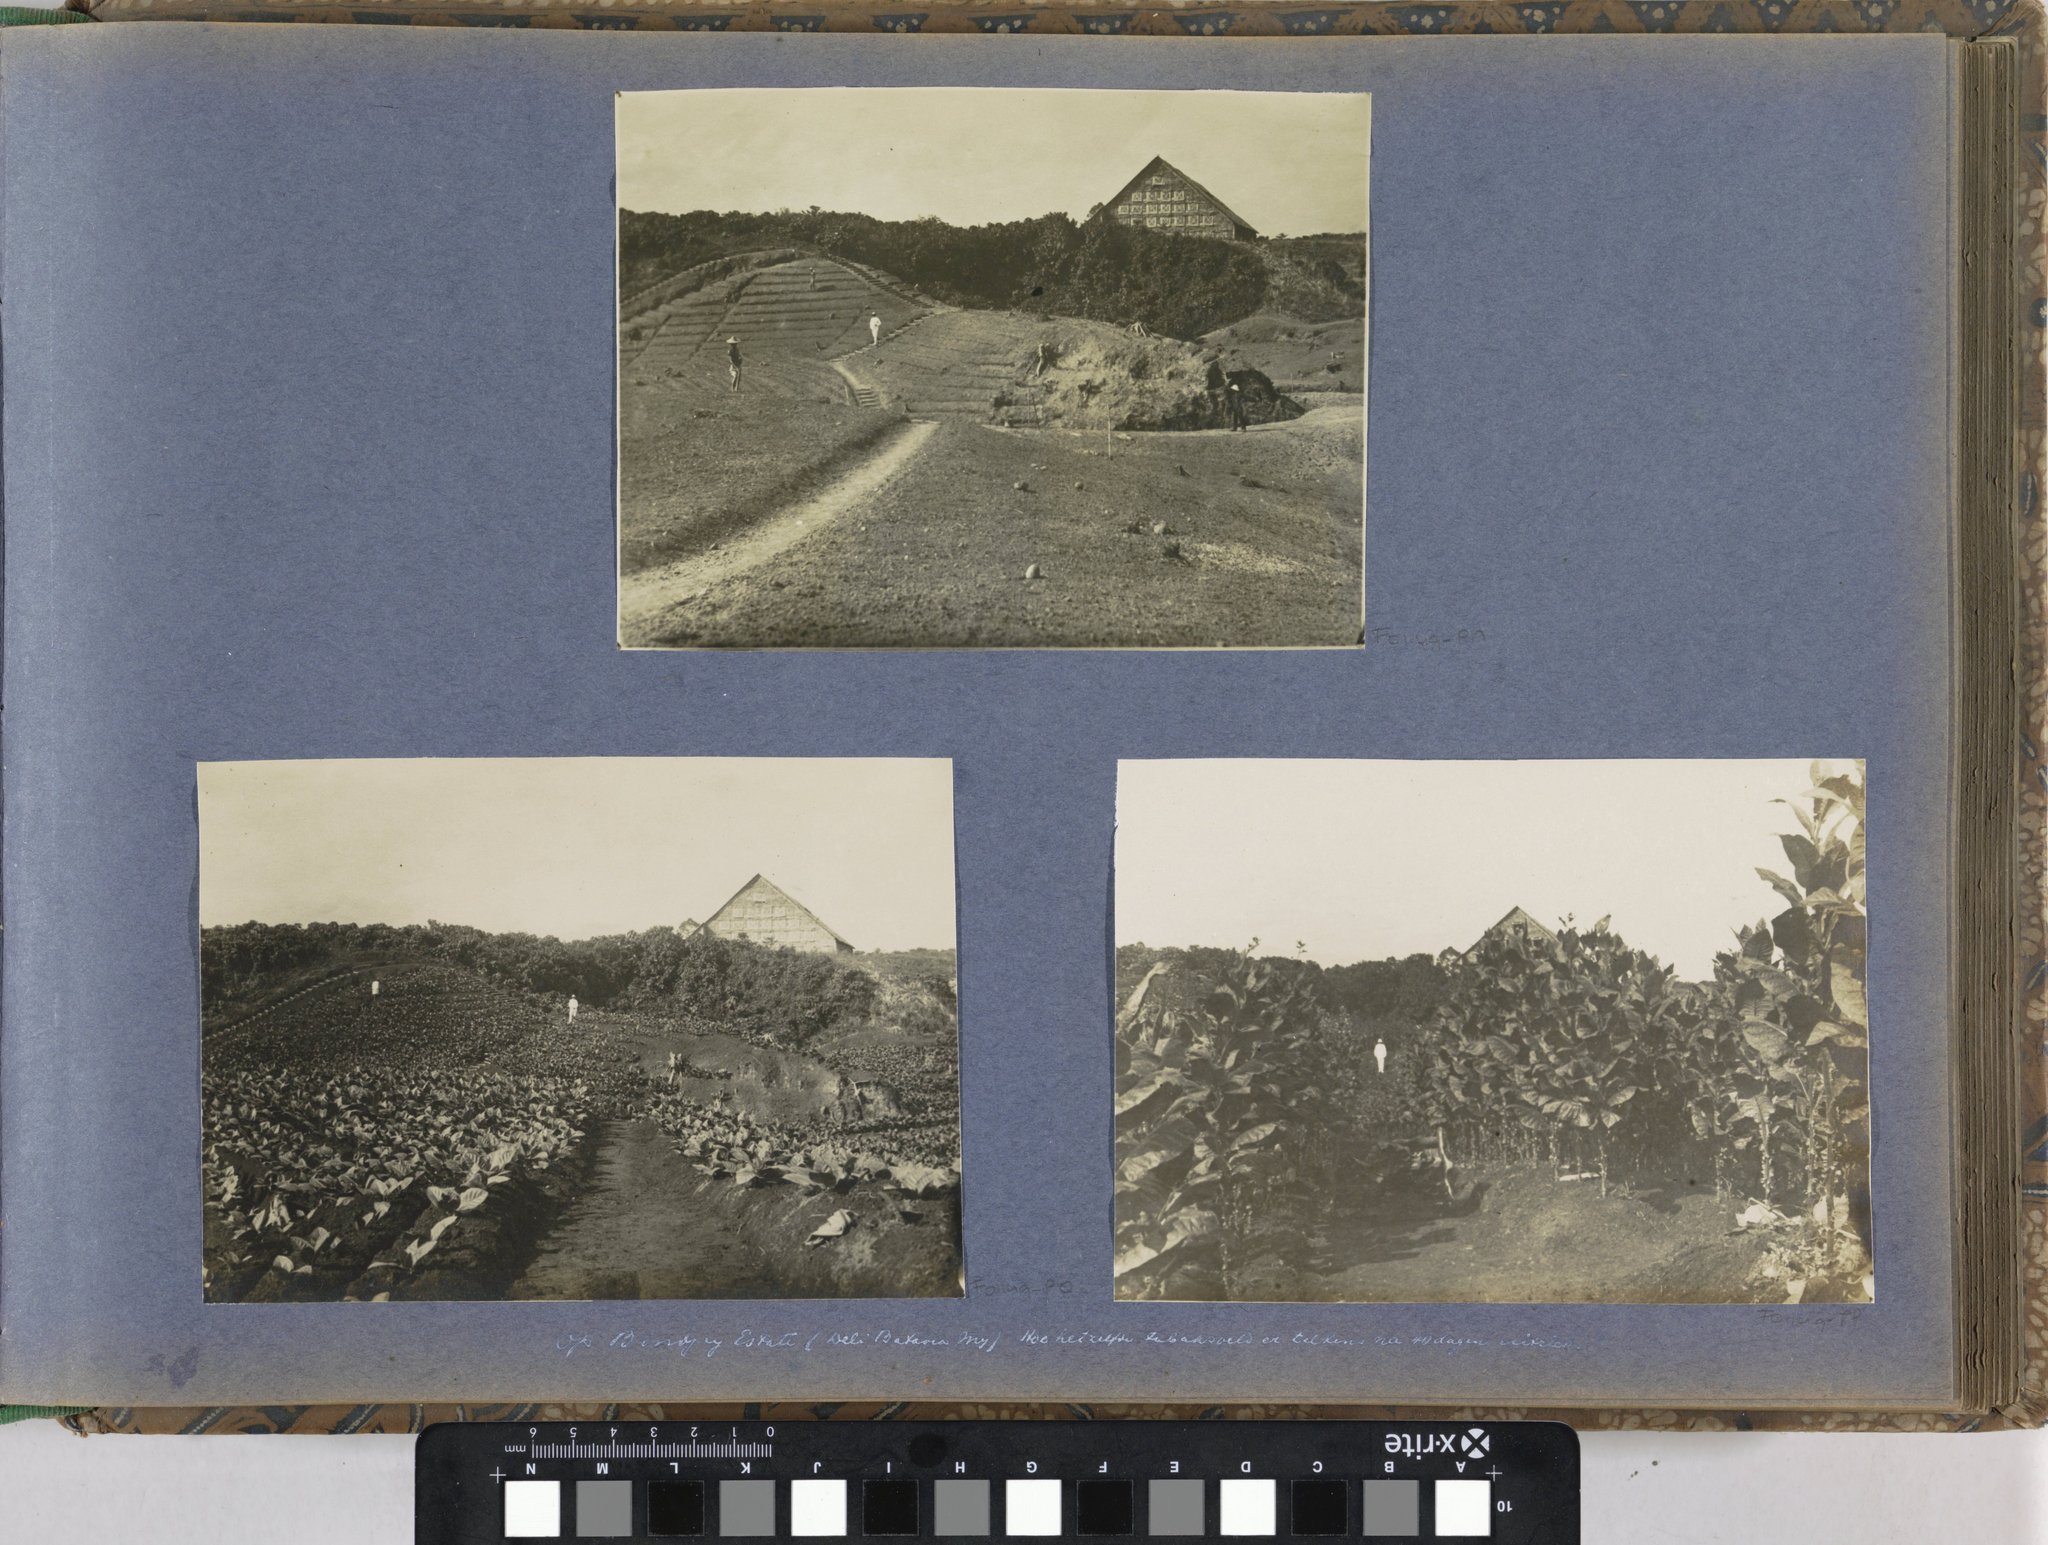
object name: photograph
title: Tabaksveld op het Bindjey Estate van de Deli-Batavia Maatschappij op Sumatra (80 dagen na aanplant)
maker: Anonymous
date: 1900-1920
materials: paper, photographic support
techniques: gelatin silver print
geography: sumatra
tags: plantation, field filled with a crop, tobacco, sumatra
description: Foto 3 uit serie van 3. Onderdeel van reisalbum met foto's van bedrijvigheid en bezienswaardigheden op Sumatra en Java en van de reis naar en van Nederlands-Indië.